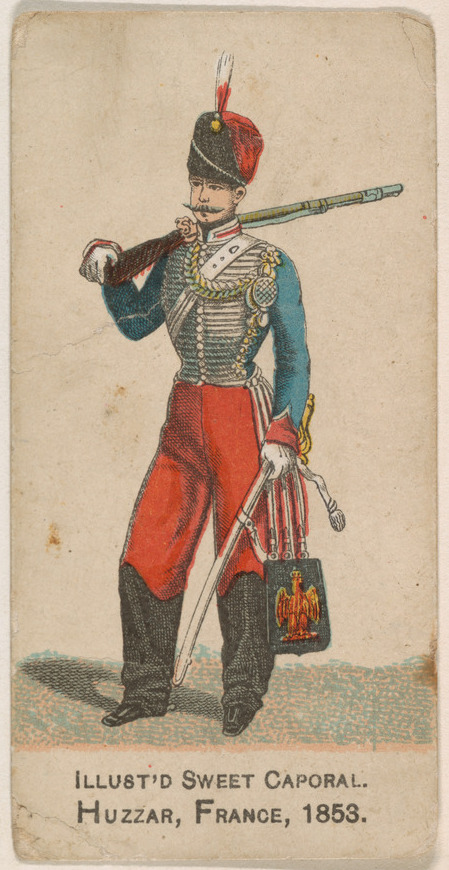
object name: print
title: Huzzar, France, 1853, from the Military Series (N224) issued by Kinney Tobacco Company to promote Sweet Caporal Cigarettes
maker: kinney brothers tobacco company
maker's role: publisher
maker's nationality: american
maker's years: 1869-2011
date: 1888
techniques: color lithograph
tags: soldiers,firearms,men